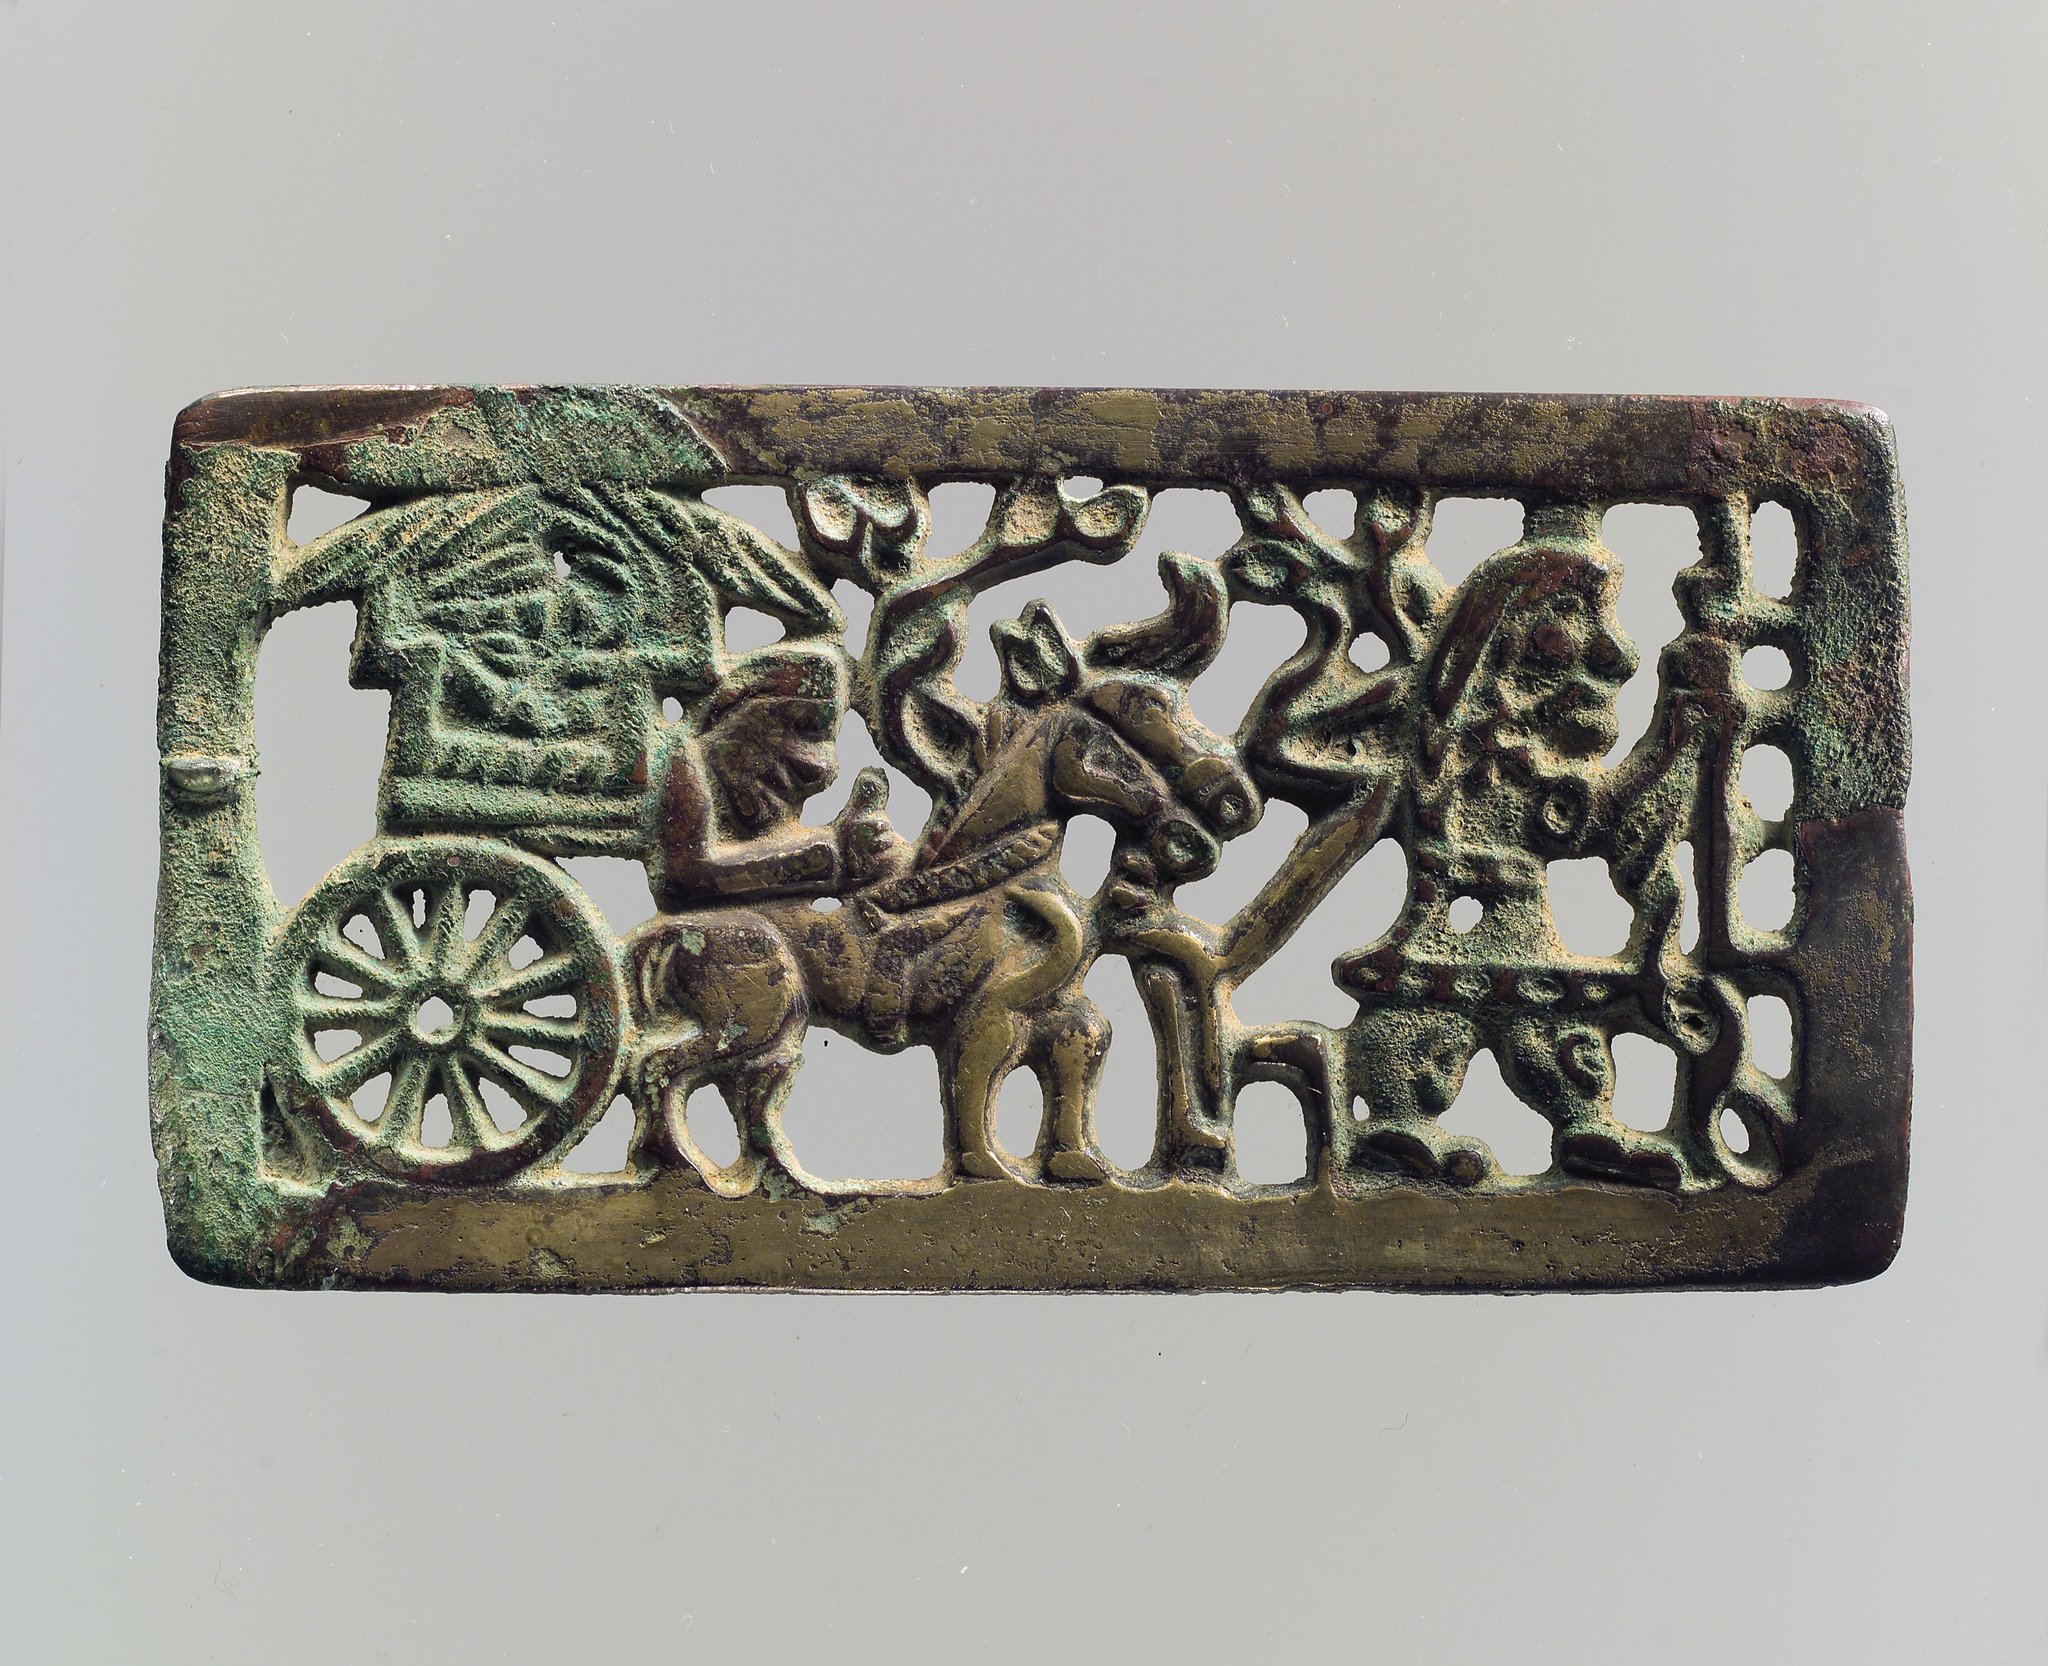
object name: plaque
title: Plaque with Horse Carriage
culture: chinese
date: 200-1 BCE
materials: bronze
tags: men,horses,carriages